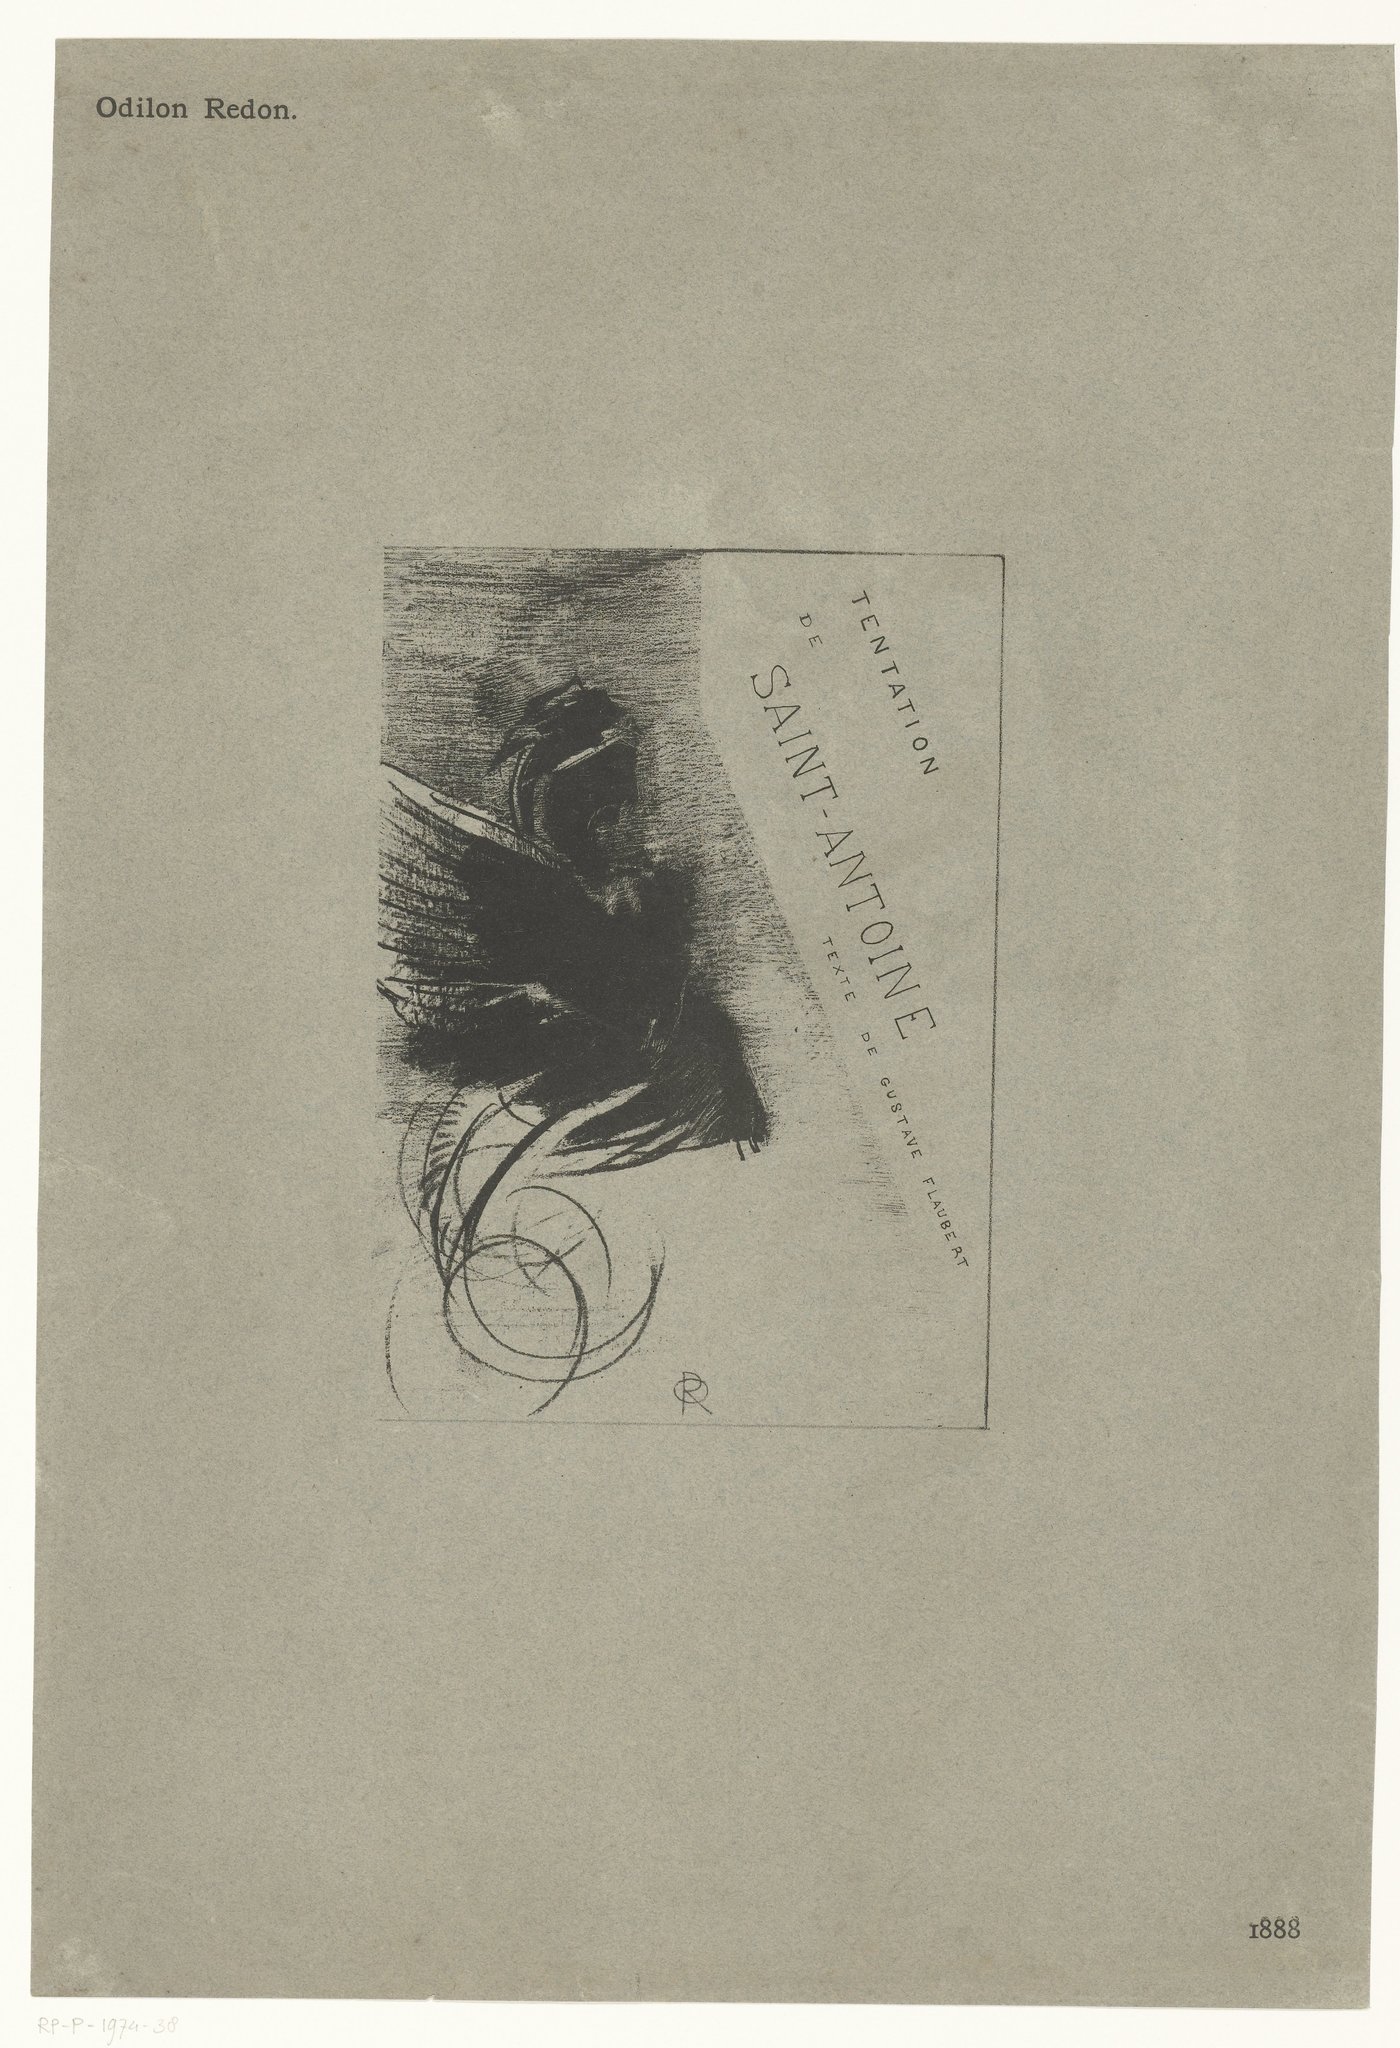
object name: titelprent, frontispice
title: Titelblad van een de serie met de verzoeking van de heilige Antonius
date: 1888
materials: paper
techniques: lithograph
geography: paris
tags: monsters of mixed human and animal shape; 'mostri' (ripa), temptations of st. antony abbot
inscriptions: collector's mark: Lugt 2228, collector's mark: Lugt 2760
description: Een vogel met een mannenkop. Titelblad voor de eerste serie van tien prenten bij Gustave Flauberts De verzoeking van de heilige Antonius.